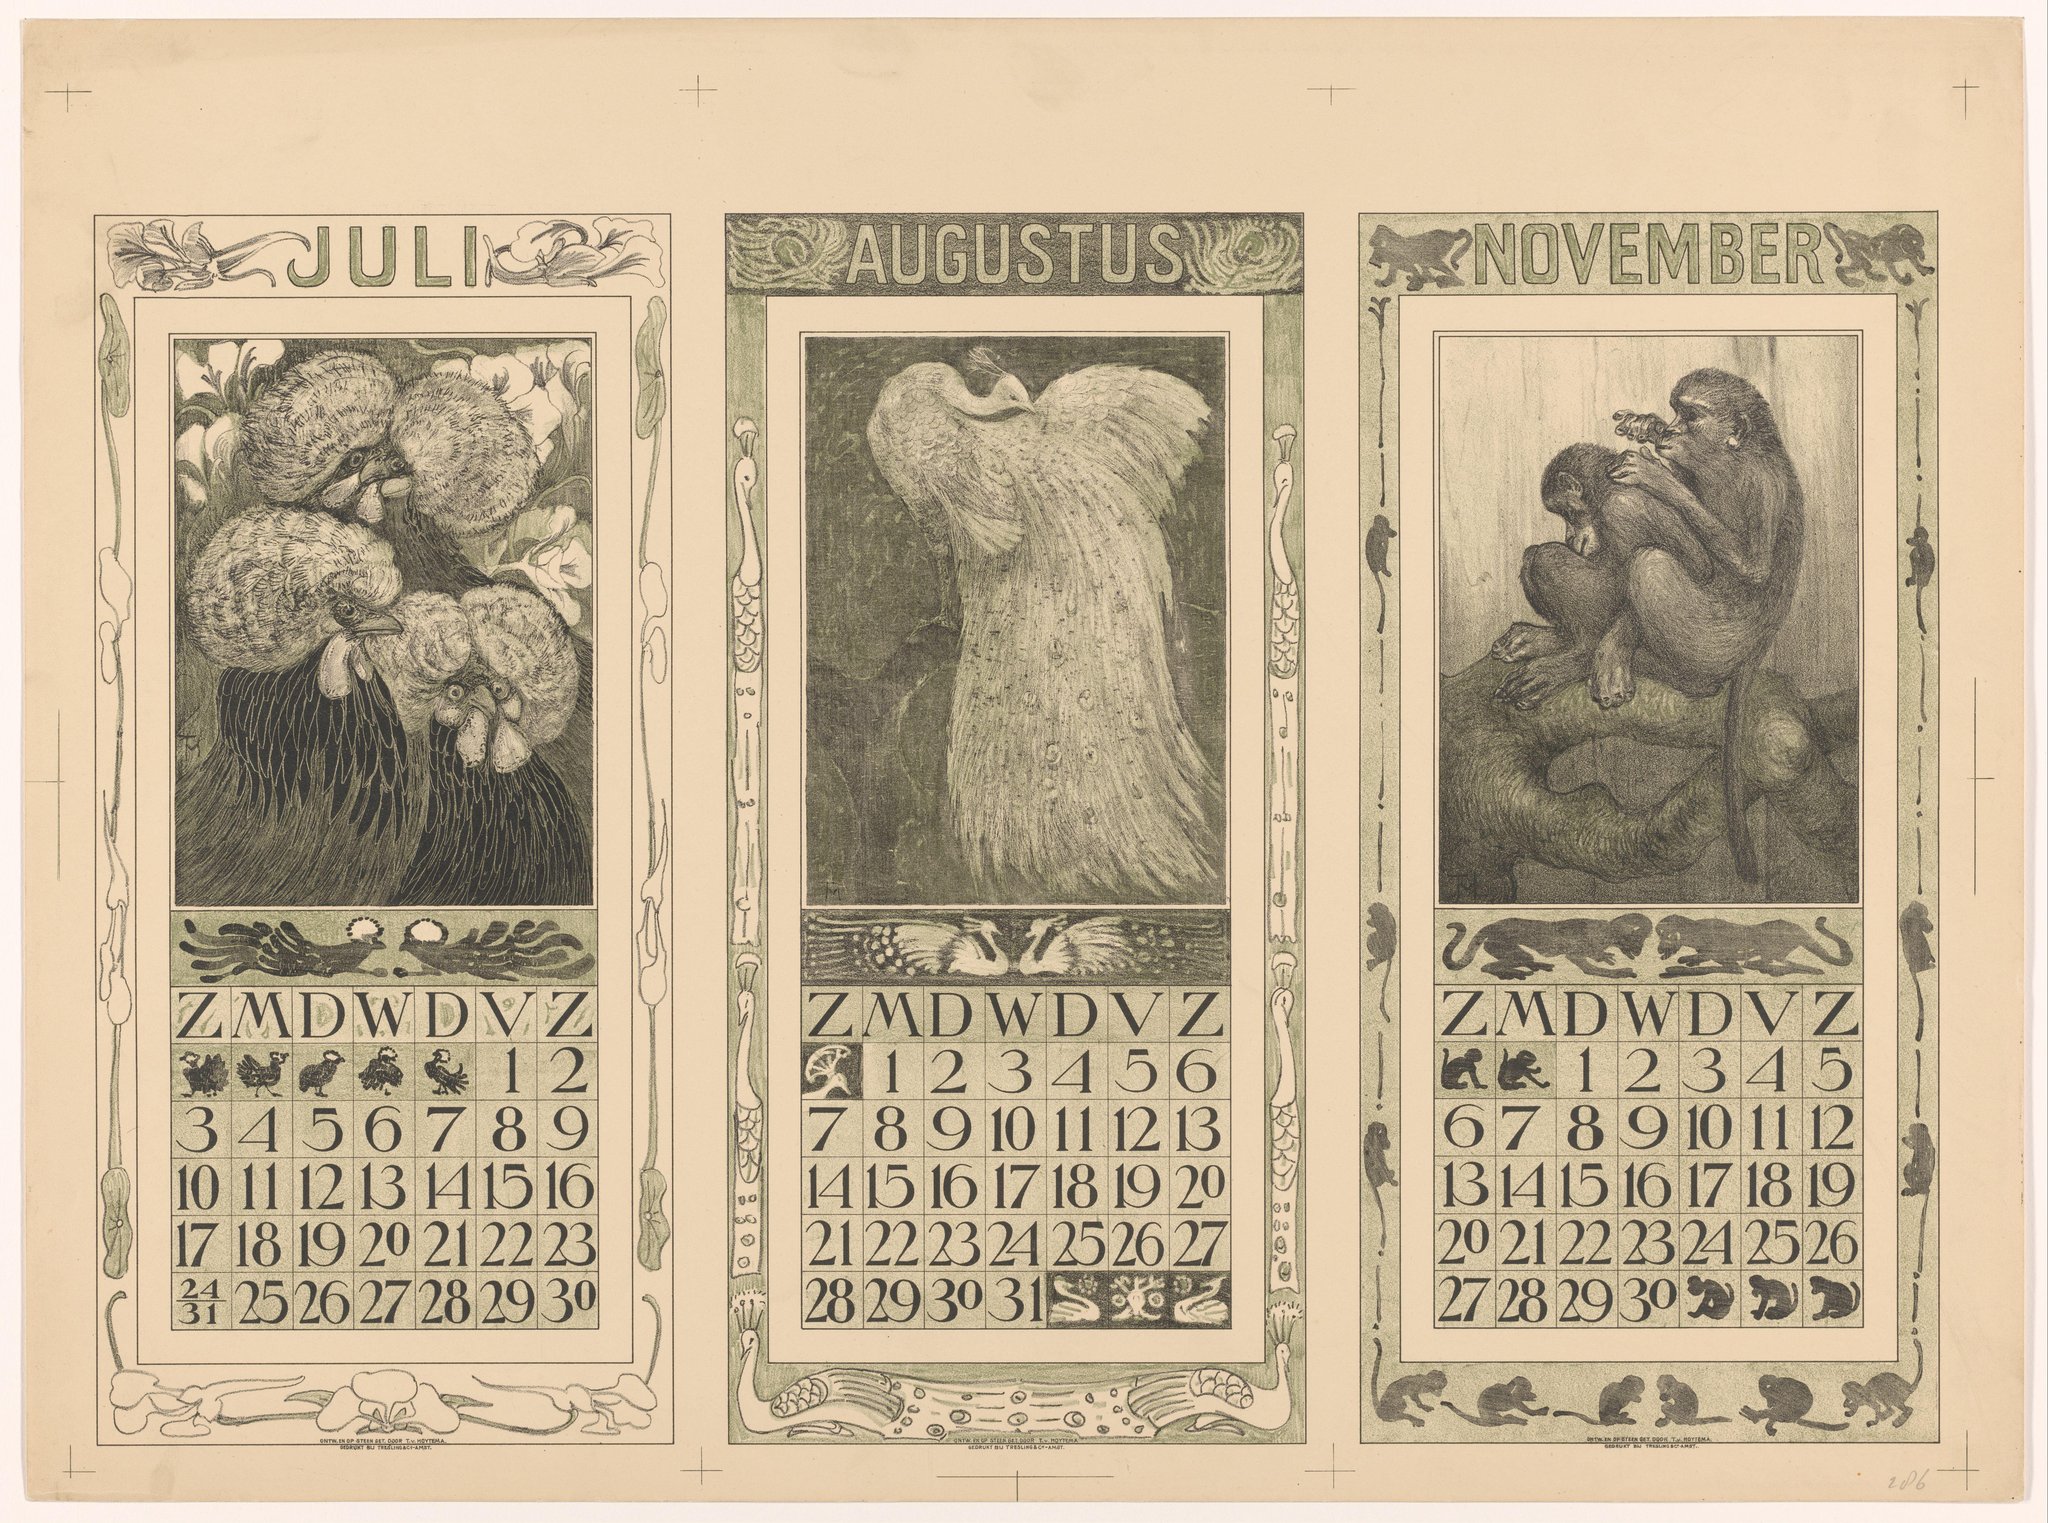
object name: print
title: Kalenders voor juli, augustus en november 1910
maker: theo van hoytema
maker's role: draughtsman, painter, print maker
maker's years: 1863-1917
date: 1910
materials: paper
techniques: lithograph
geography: the hague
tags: calendar, almanac, monkeys, apes, ornamental birds: peacock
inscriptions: collector's mark: Lugt 2228, collector's mark: Lugt 4731